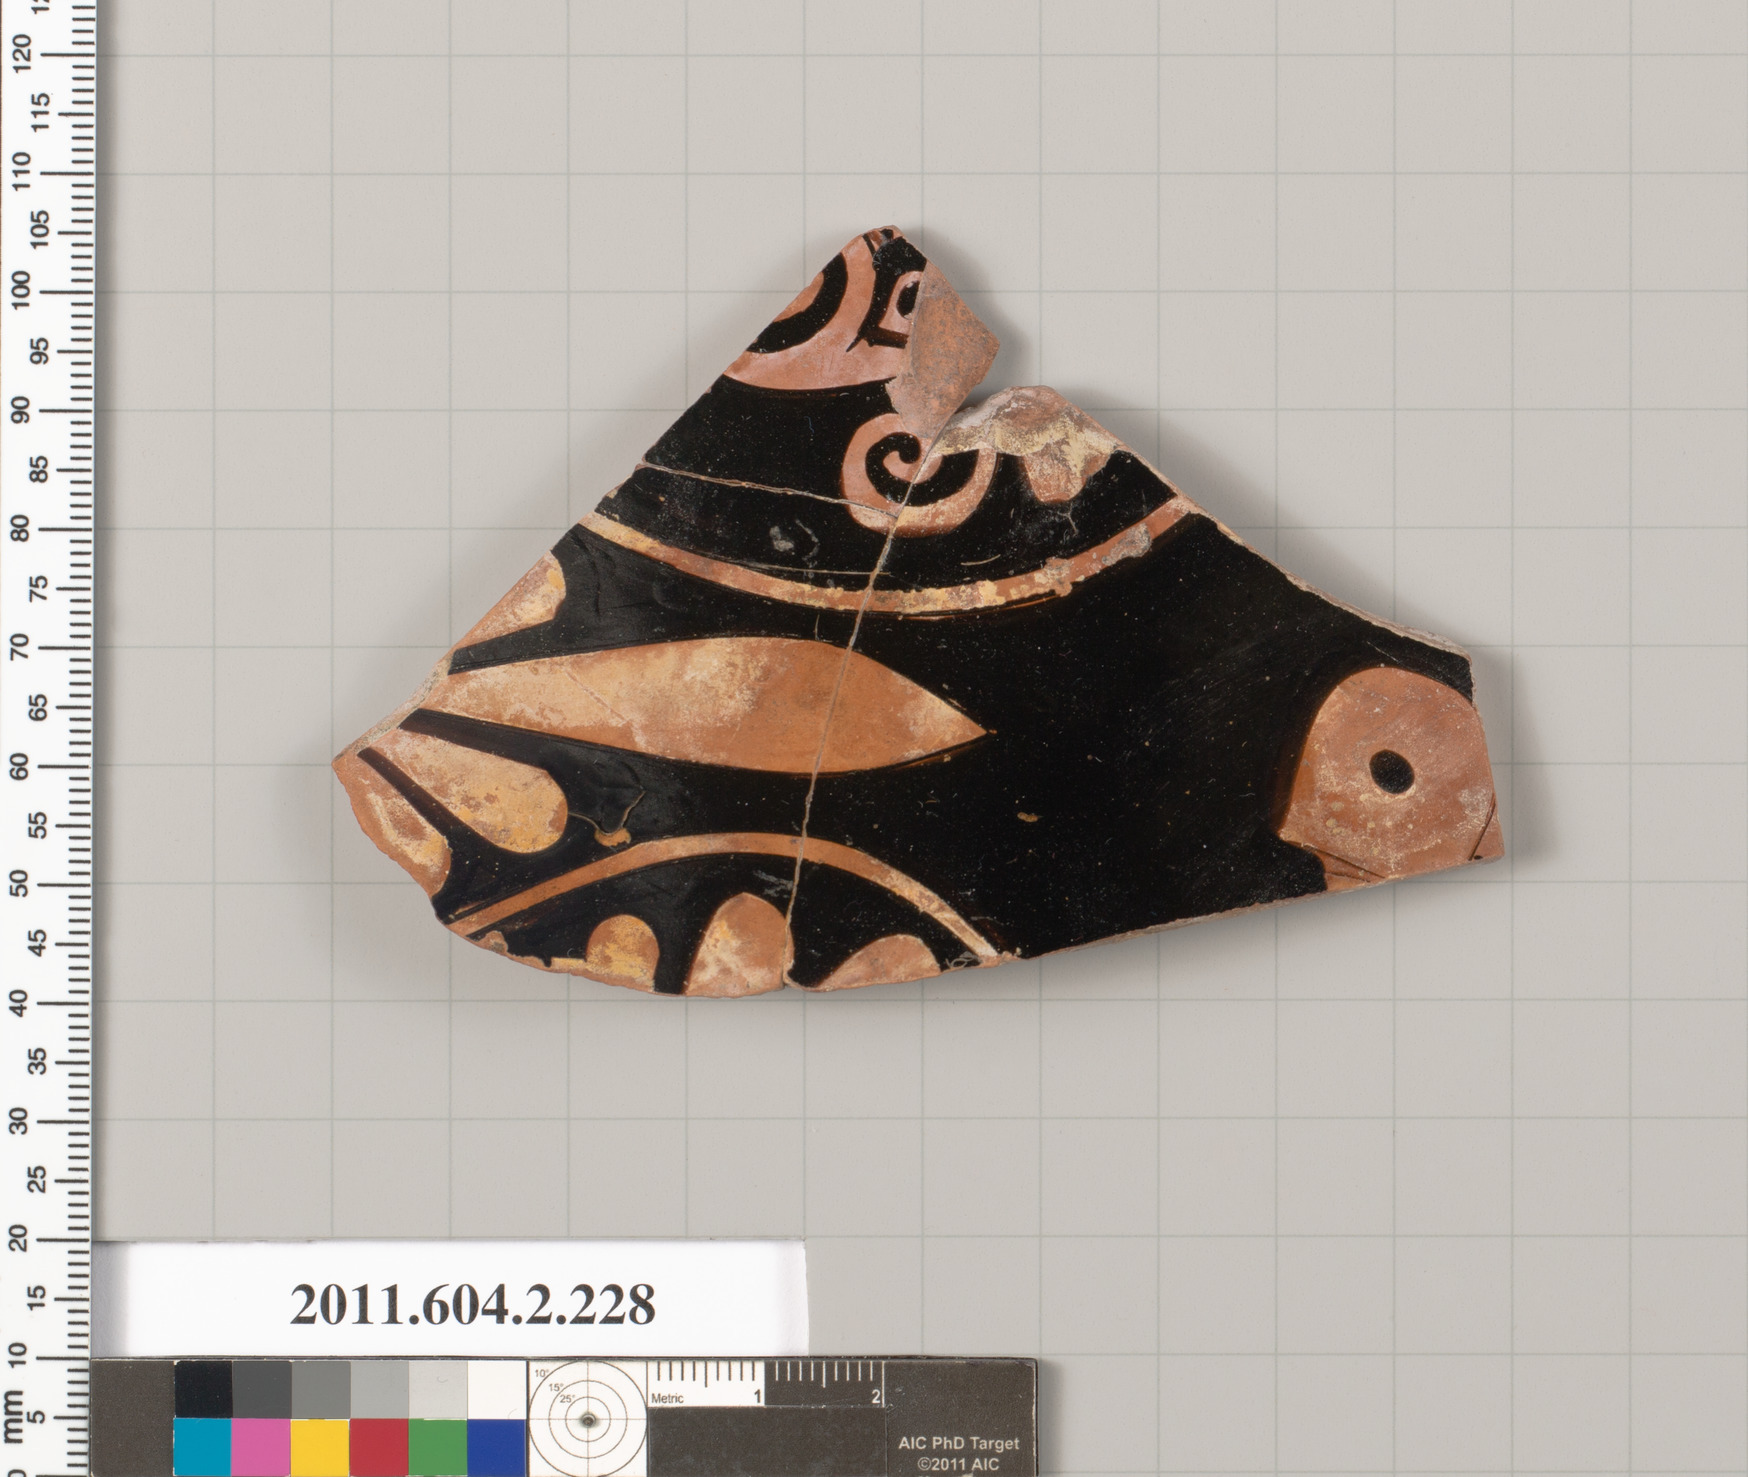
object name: stamnos fragment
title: Terracotta fragment of a stamnos (jar)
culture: greek, attic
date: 480-470 BCE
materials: terracotta